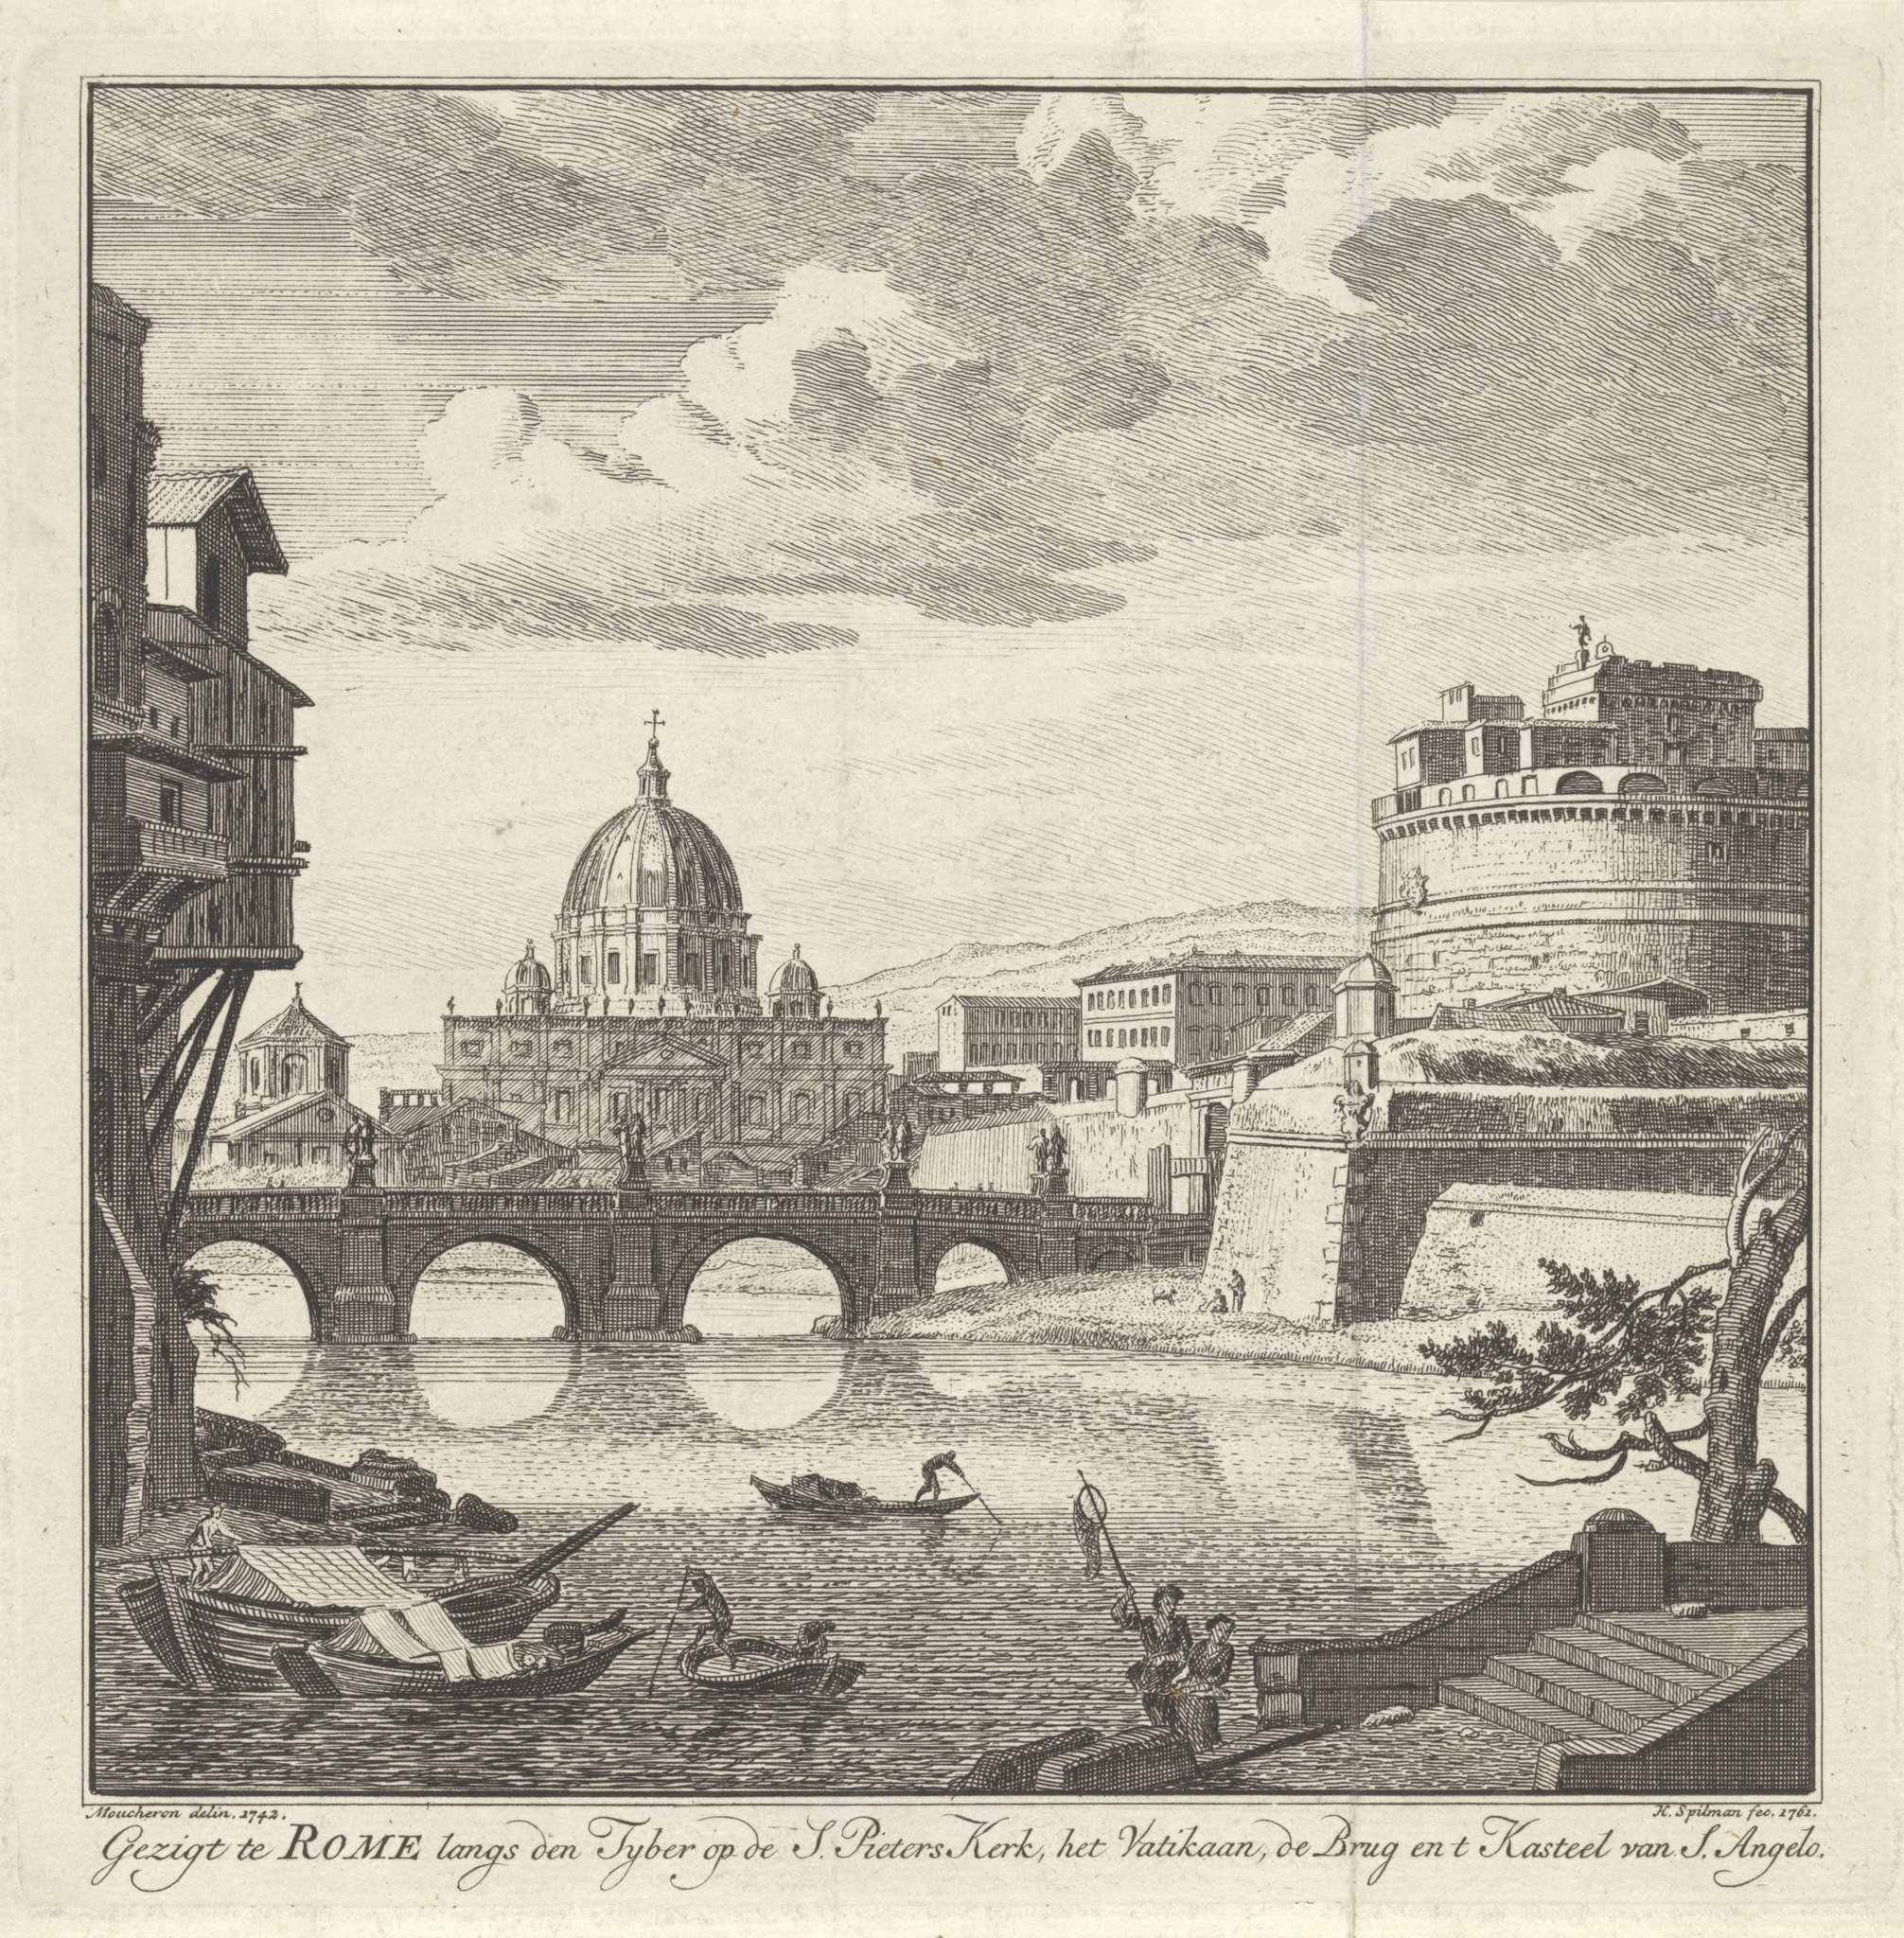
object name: print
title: Gesigt te Rome langs den Tyber op de S.PietersKerk, het Vatikaan, de Brug en t Kasteel van S.Angelo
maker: hendrik spilman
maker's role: draughtsman, painter, print maker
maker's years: 1721-1784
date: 1742-1784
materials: paper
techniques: etching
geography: haarlem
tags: engelenburcht, sint-pietersbasiliek, engelenbrug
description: Gezicht op Rome vanaf de Tiber, op de Sint-Pietersbasiliek, de Engelenbrug en -burcht.